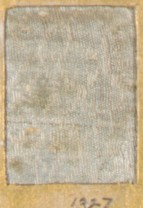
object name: piece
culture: japanese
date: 1701-1900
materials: silk